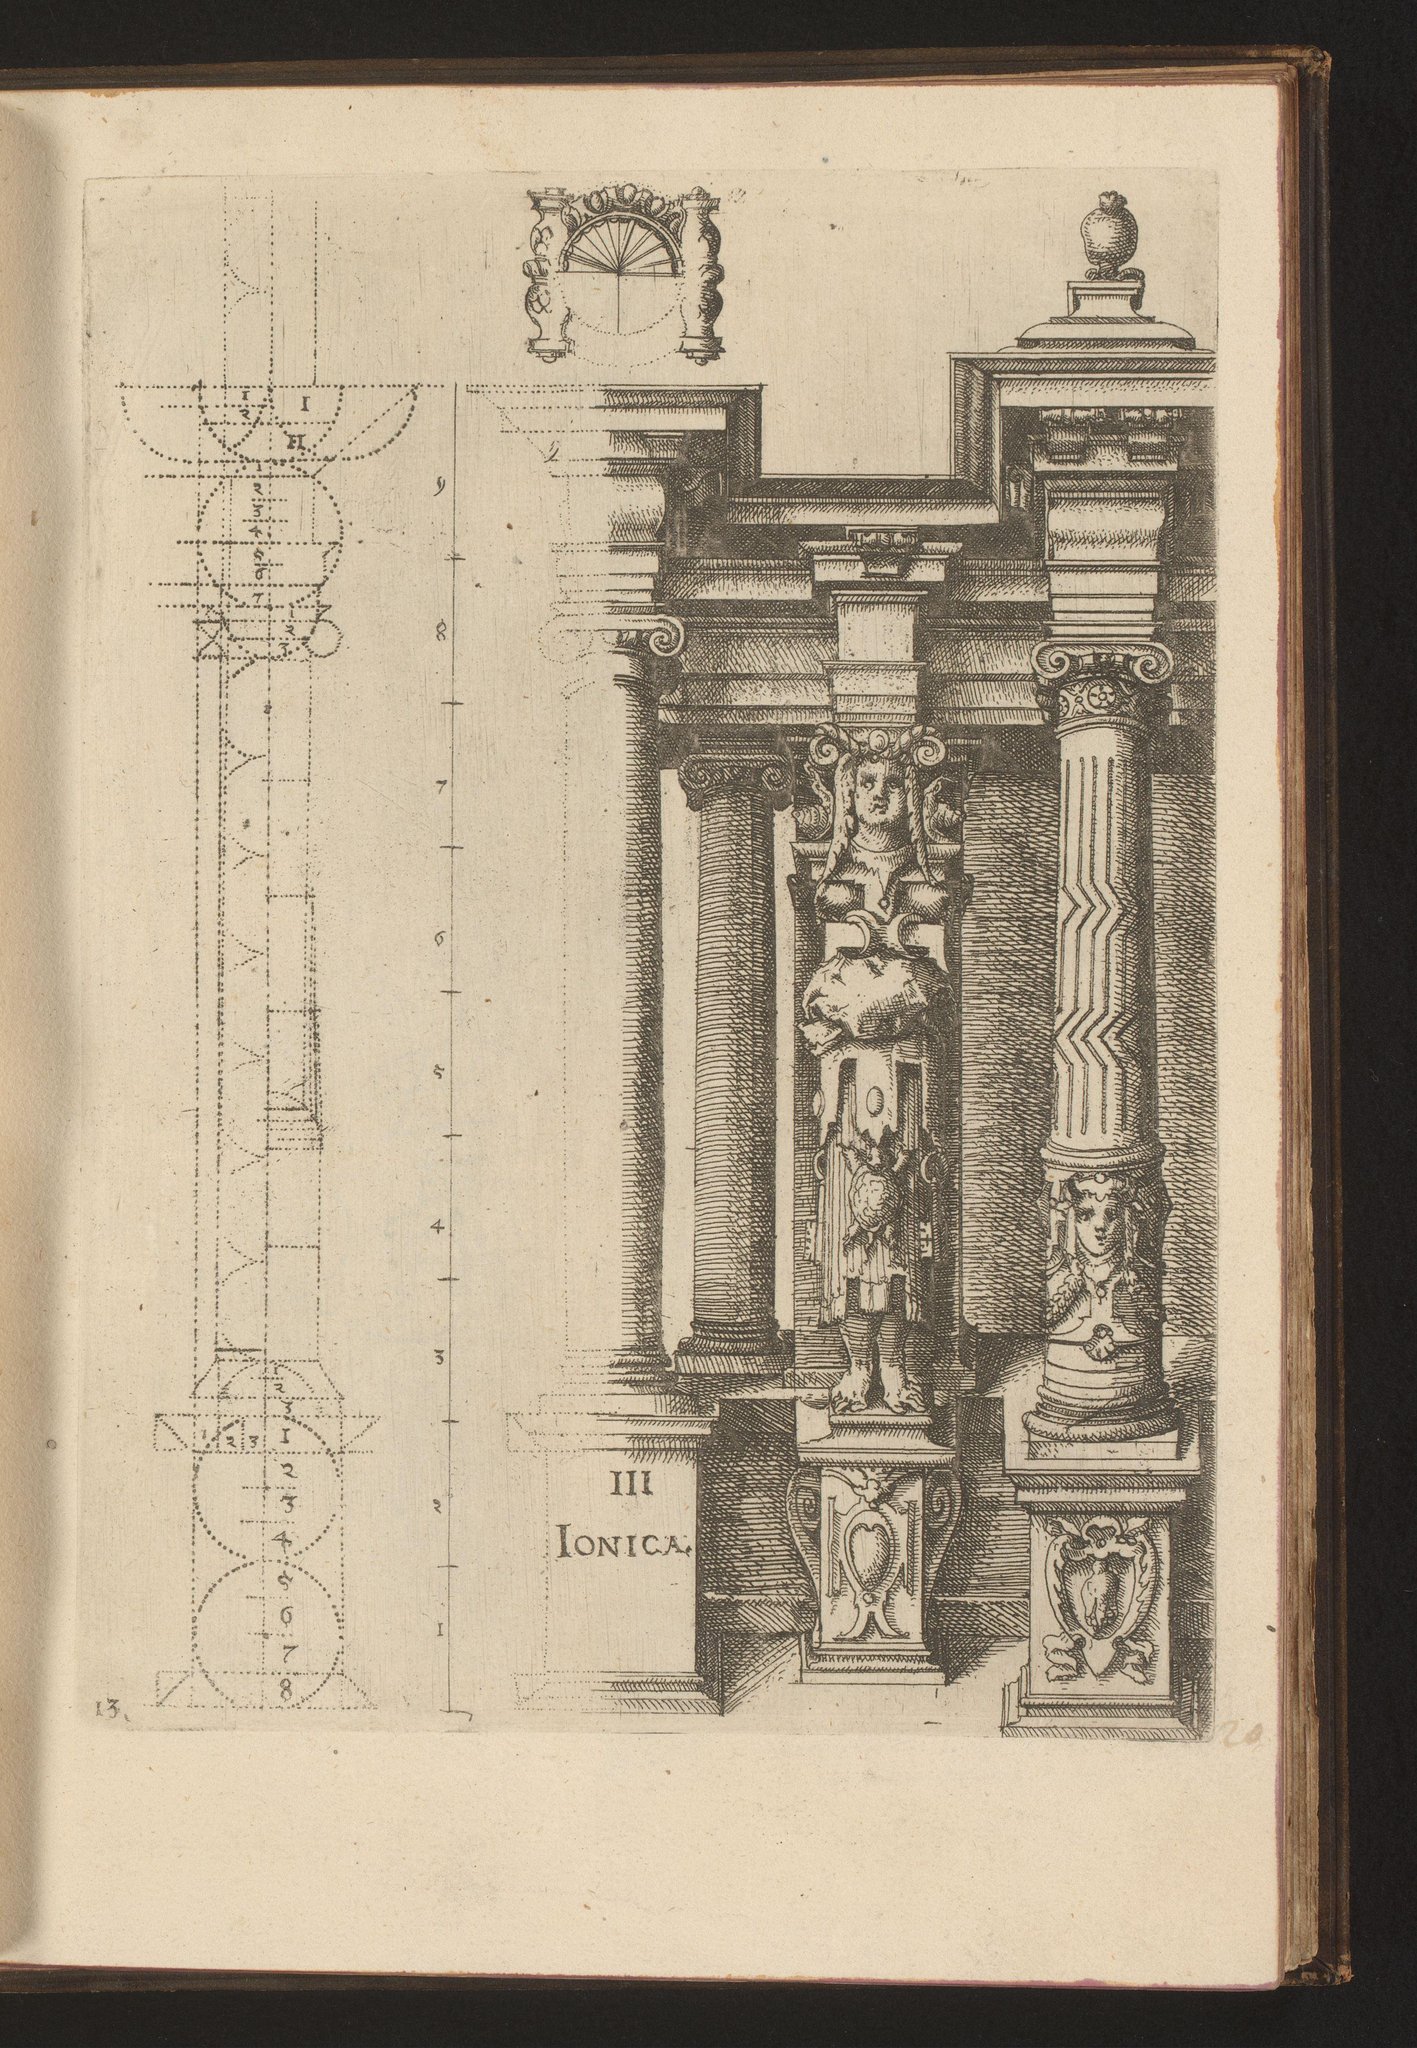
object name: page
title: Architectura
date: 1593-1595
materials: paper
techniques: etching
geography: straatsburg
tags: column, pillar ~ architecture, caryatids ~ architecture, other architectural details, ionic order ~ architecture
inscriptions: collector's mark: Lugt 2760, collector's mark: Lugt 2228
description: Prent gebruikt in: Dietterlin, Wendel (I). Architectura de quinq[ue] columnarum simmetrica distributione et variis eorundem or namentis: Liber I. Straatsburg: Bernhard Jobin, 1593.